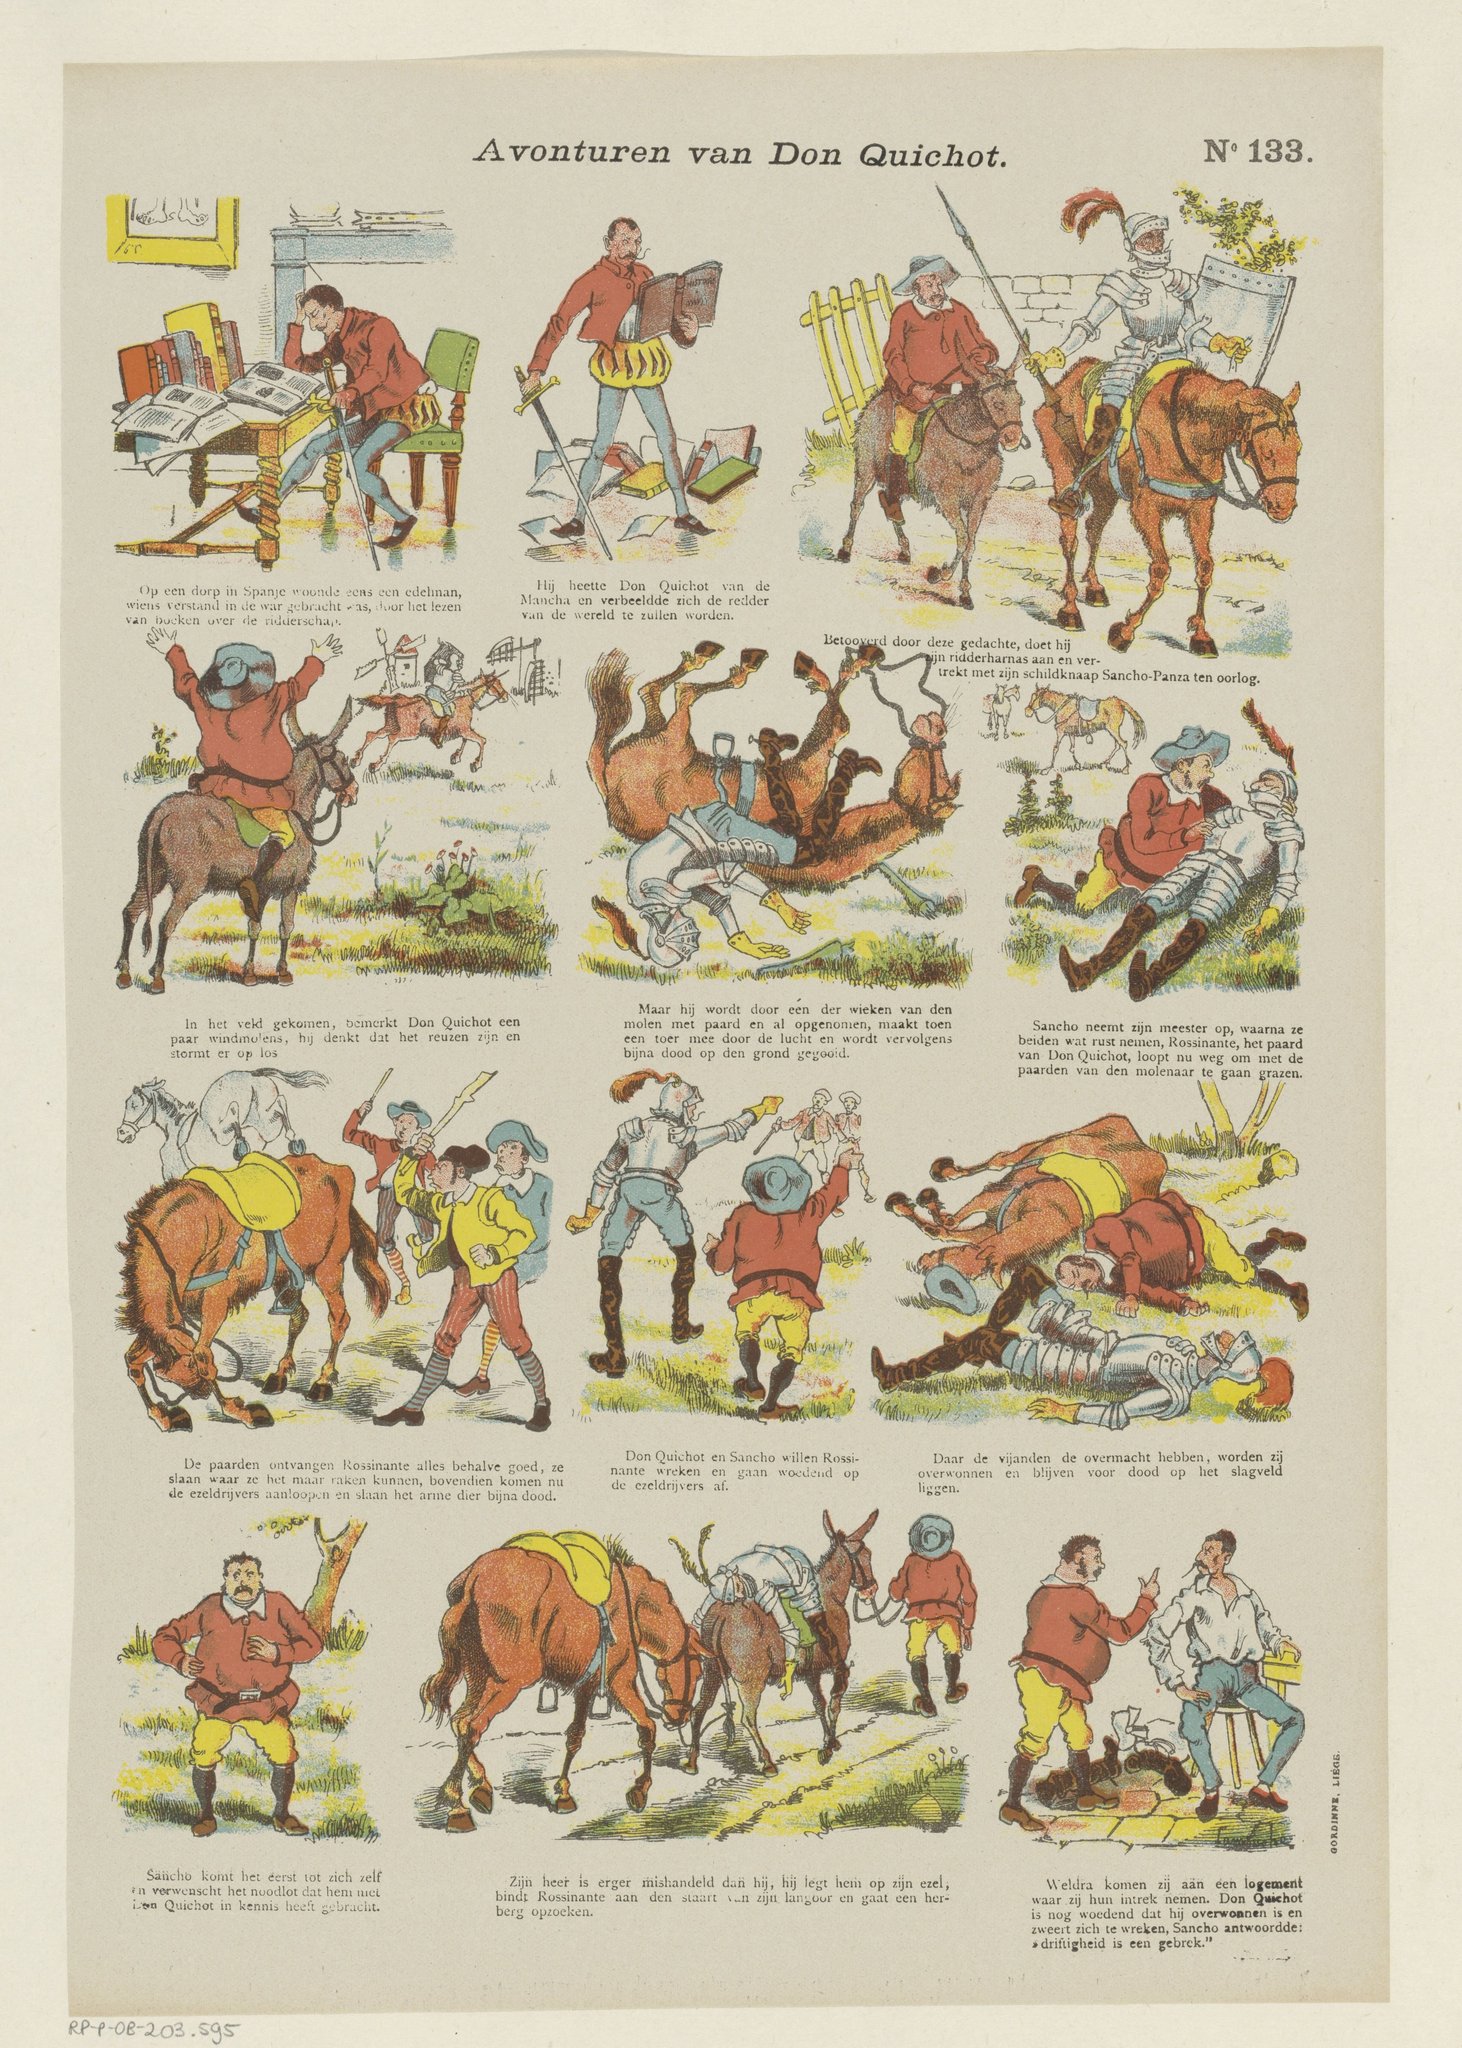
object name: print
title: Avonturen van Don Quichot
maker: lamouche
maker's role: print maker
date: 1894-1959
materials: paper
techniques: lithograph, letterpress printing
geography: liège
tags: don quixote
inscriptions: collector's mark: Lugt 2760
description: Blad met 12 voorstellingen uit het verhaal van Don Quichot. Onder elke afbeelding een onderschrift. Genummerd rechtsboven: No 133.